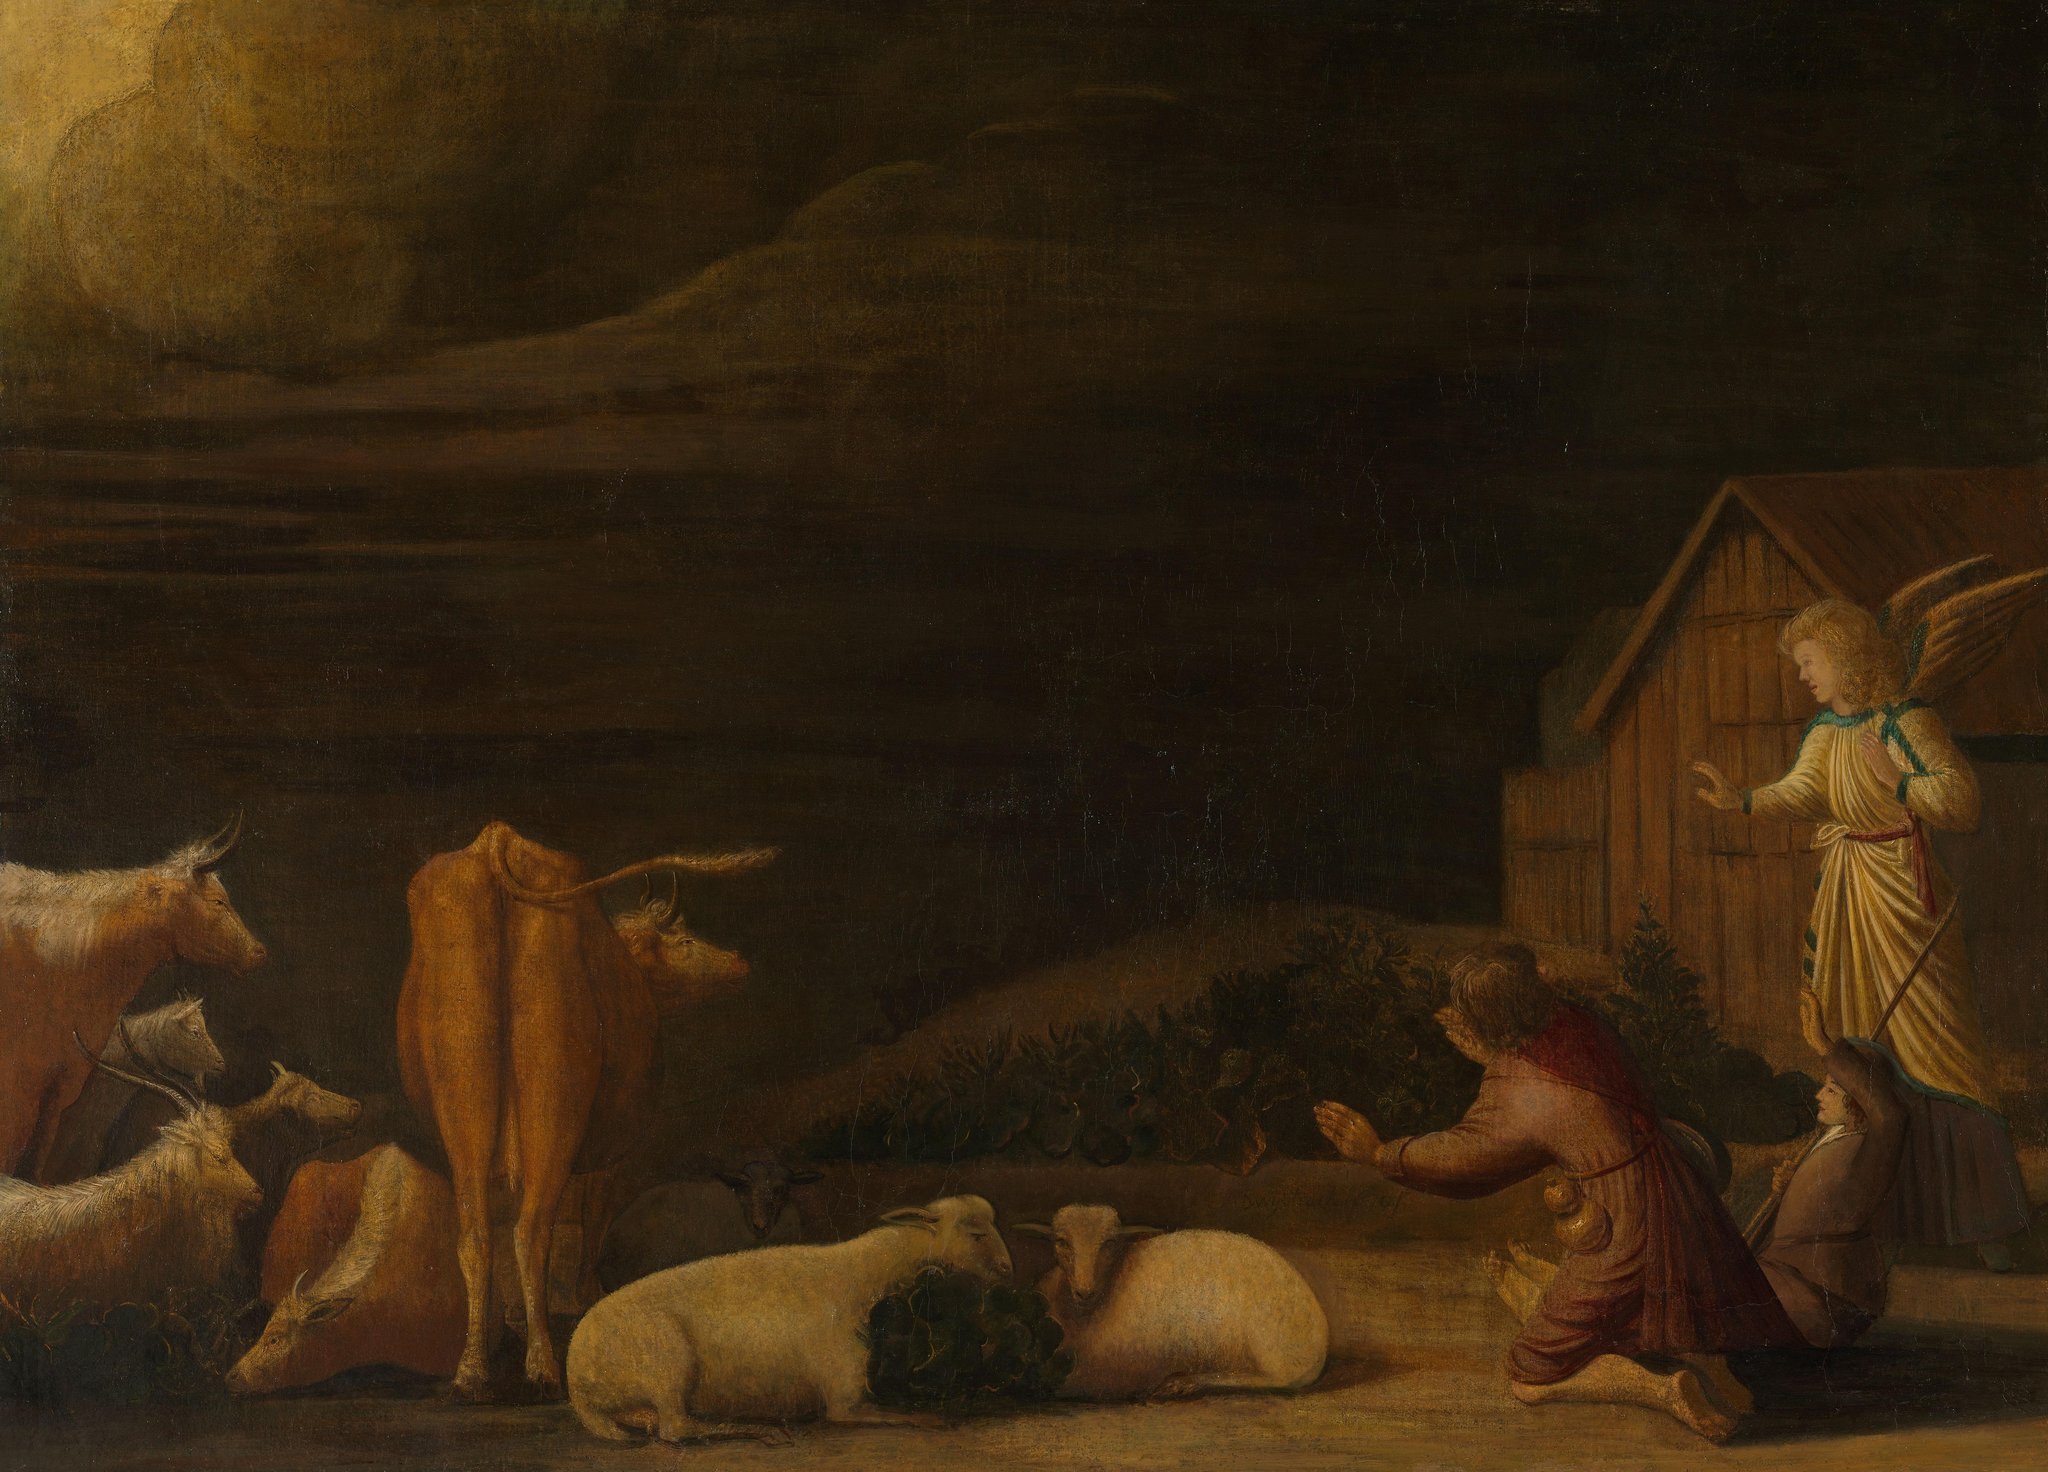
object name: painting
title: Annunciation to the Shepherds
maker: dirck wijntrack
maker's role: draughtsman, painter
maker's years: 1625-1678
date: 1630-1640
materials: canvas, oil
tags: annunciation of christ's birth to the shepherds (and/or shepherdesses) at night; a host of singing angels in the air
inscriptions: signature and date, lower centre, above the right-hand sheep: ‘D. Wijntrack 16[.]0.F.’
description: De verkondiging aan de herders. Twee herders knielend bij hun vee, achter hen verschijnt een engel.